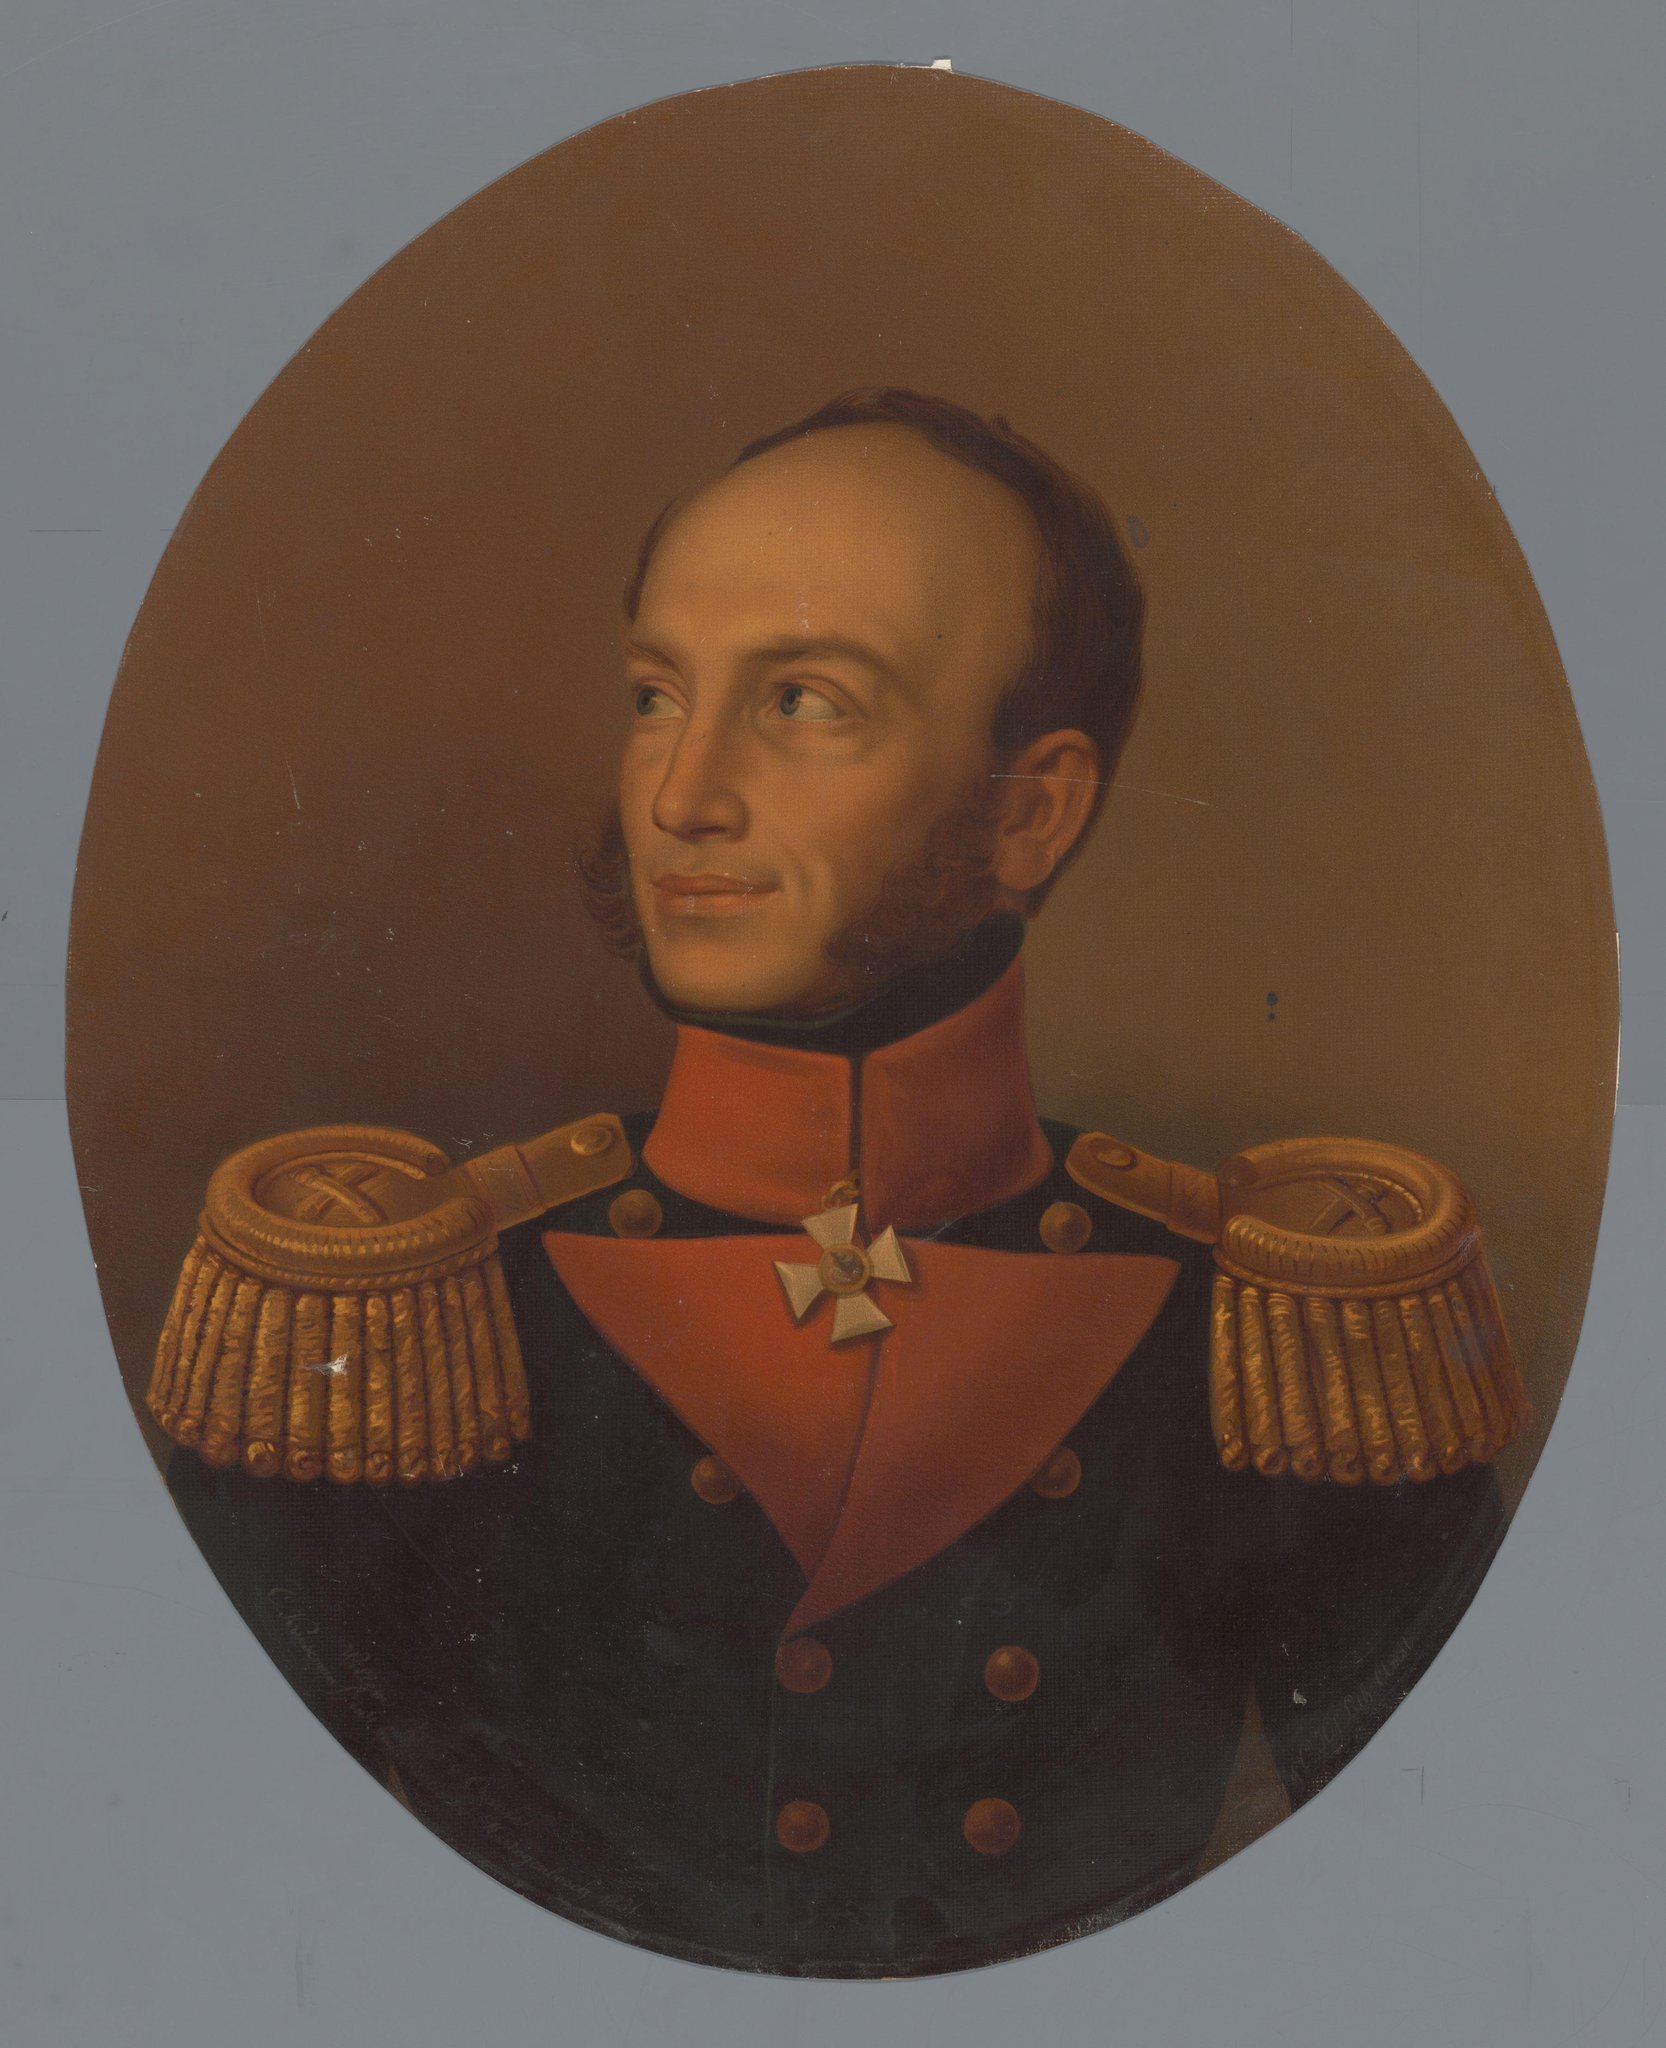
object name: print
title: Portret van Prins Willem van Oranje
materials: linen, paper, varnish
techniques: chromolithography, oleograph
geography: den bosch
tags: the hague, william ii of the netherlands, historical persons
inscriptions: inscription: ‘C. Kruseman f. in 't hoofdkwartier 's Hertogenbosch 1831’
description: Portret van Prins Willem van Oranje, borststuk naar links, in uniform met een onderscheidingsteken aan de kraag. Zonder hoofddeksel. Rode kraag en goudkleurige knopen en epauletten.